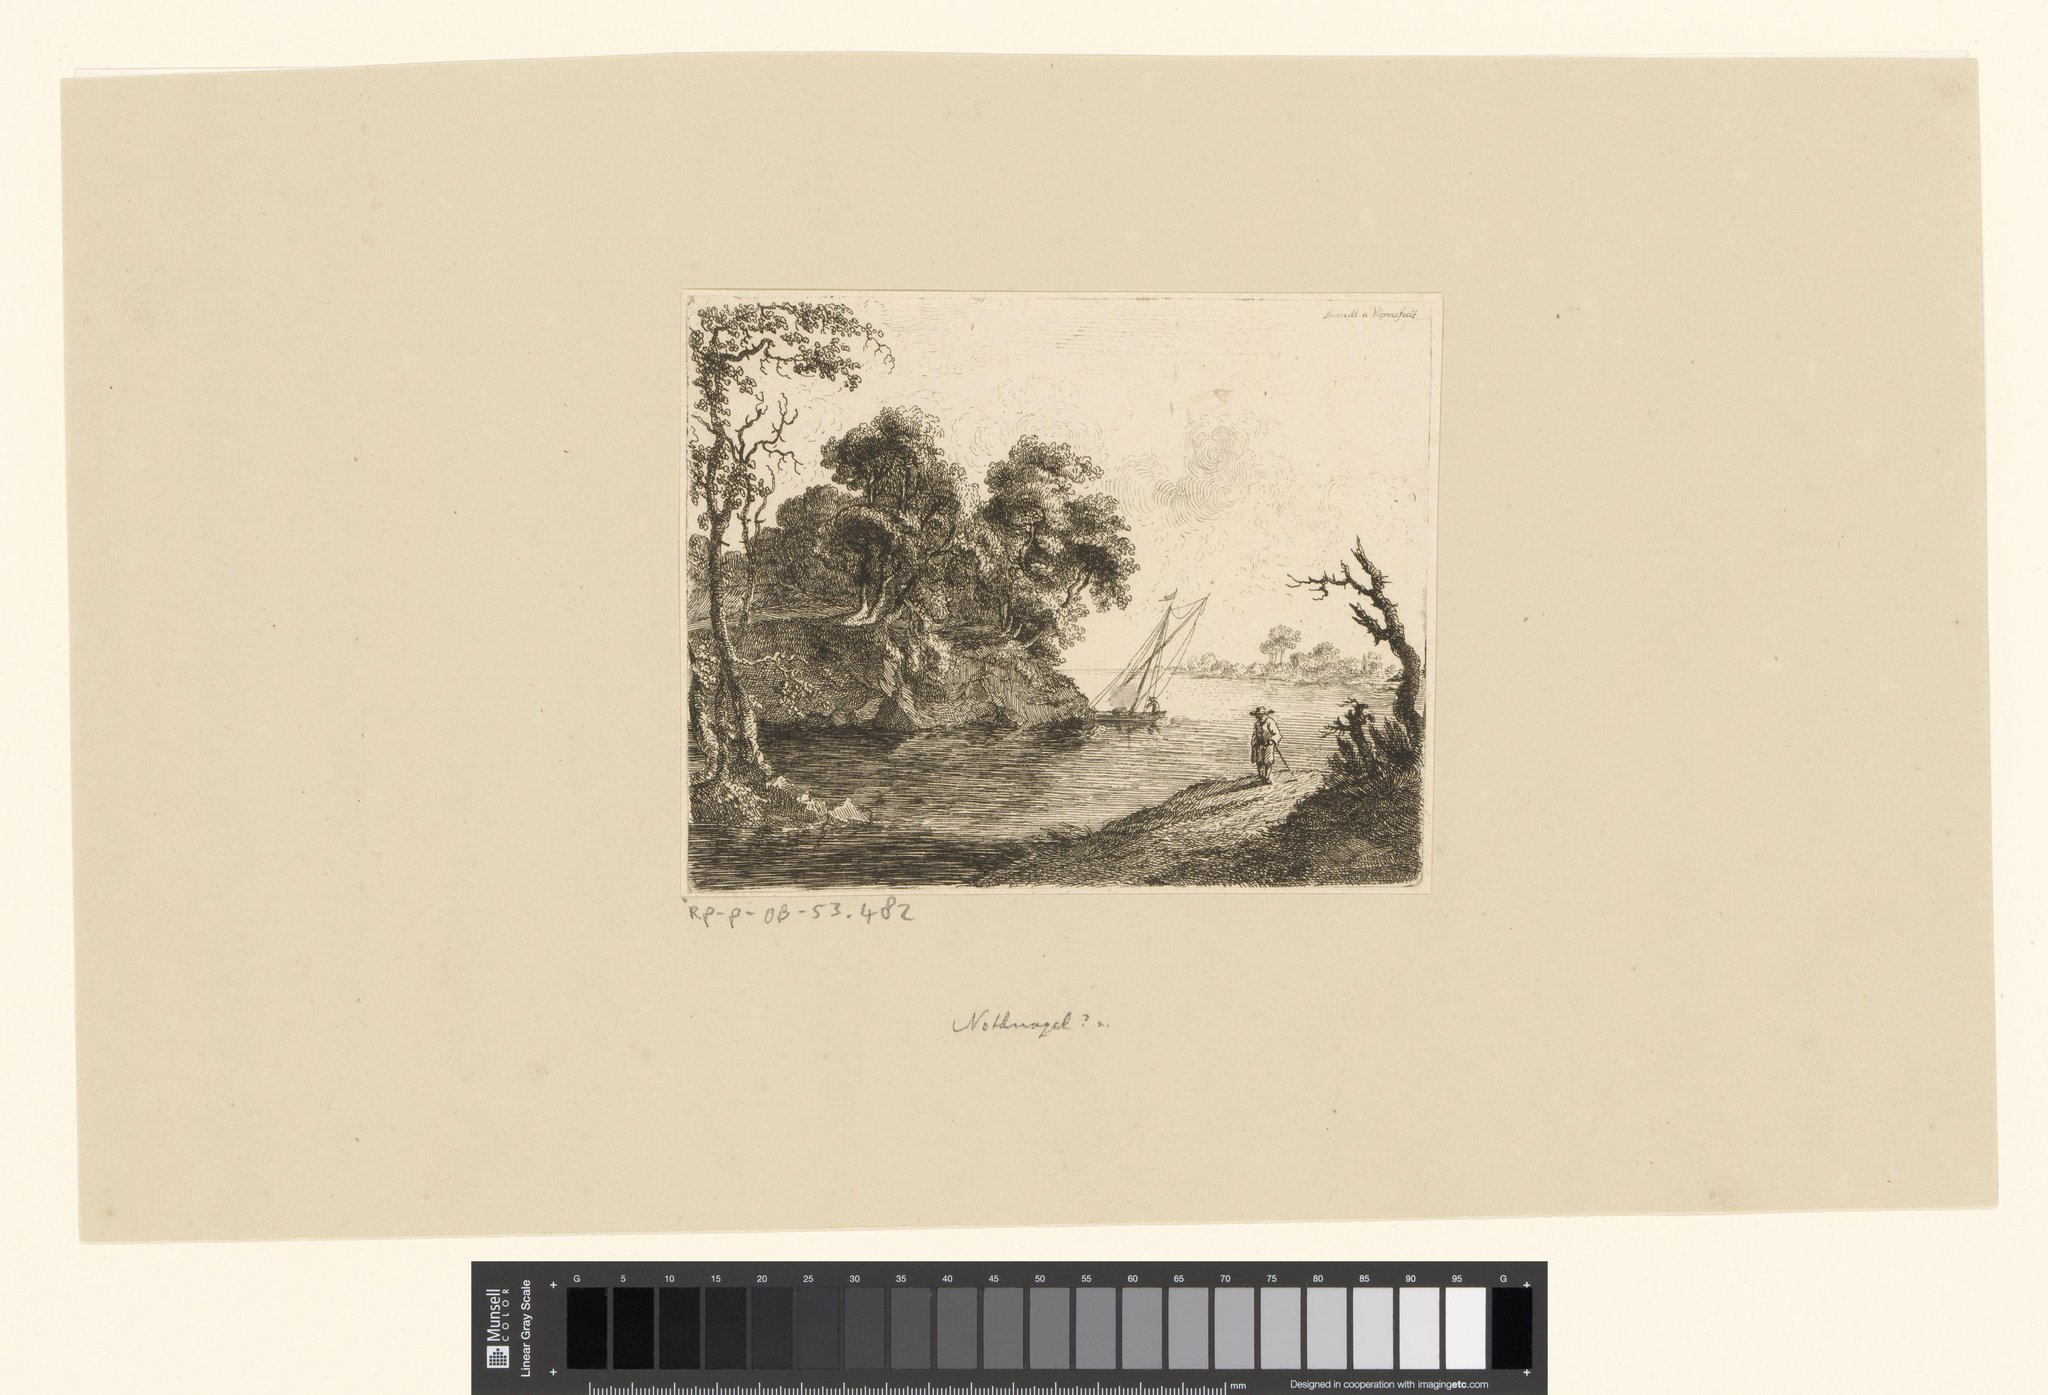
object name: print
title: Paysages gravé d'aprés des tableaux originales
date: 1739-1804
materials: paper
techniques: etching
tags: landscapes with waters, waterscapes, seascapes (in the temperate zone)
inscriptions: collector's mark: Lugt 240